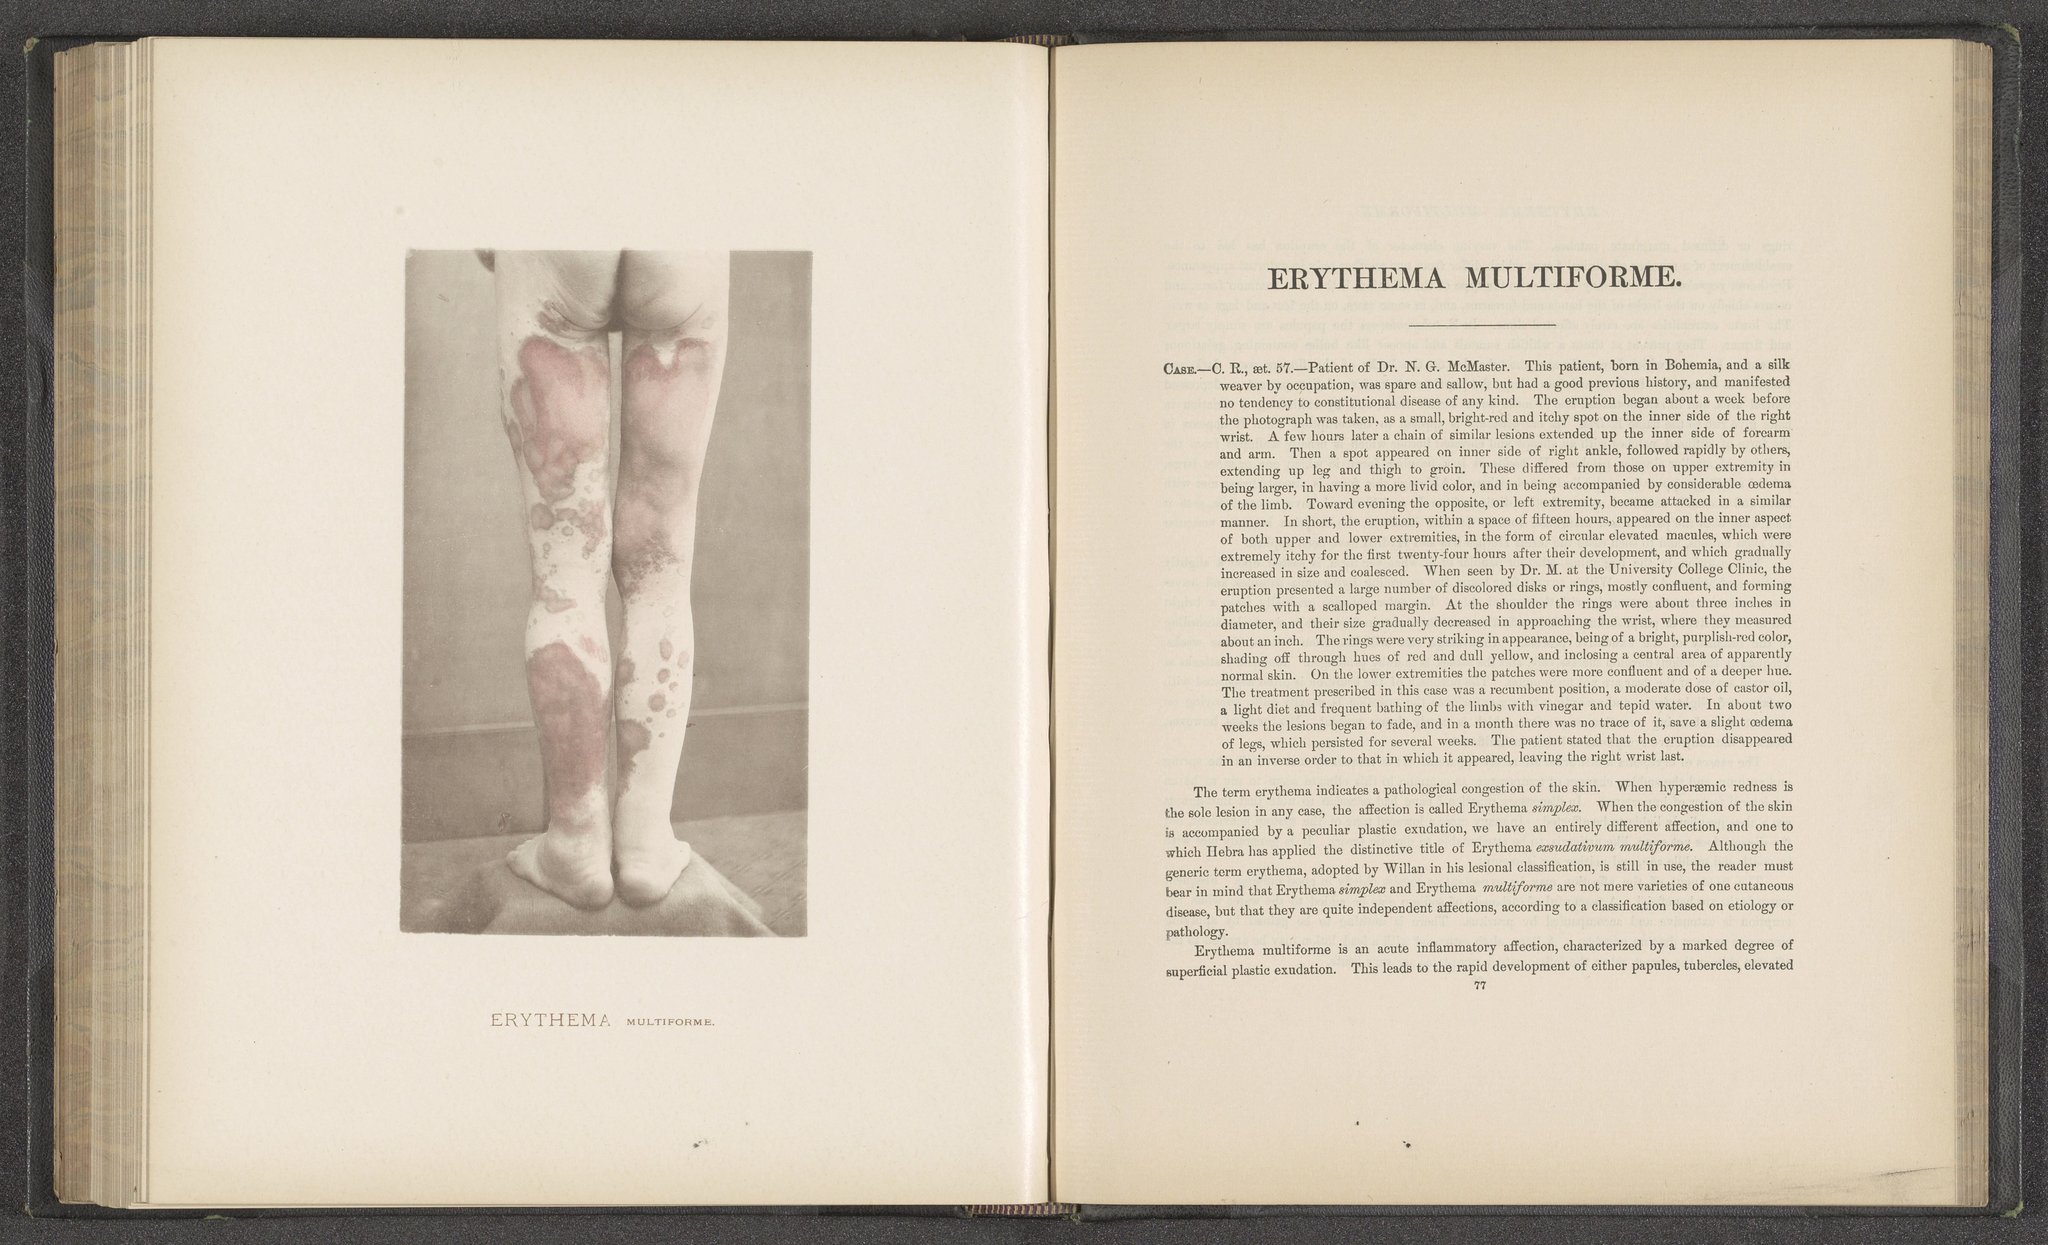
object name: photomechanical print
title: Erythema multiforme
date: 1870-1881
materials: paper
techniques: photograph, hand coloring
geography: new york city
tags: skin and venereal diseases, legs